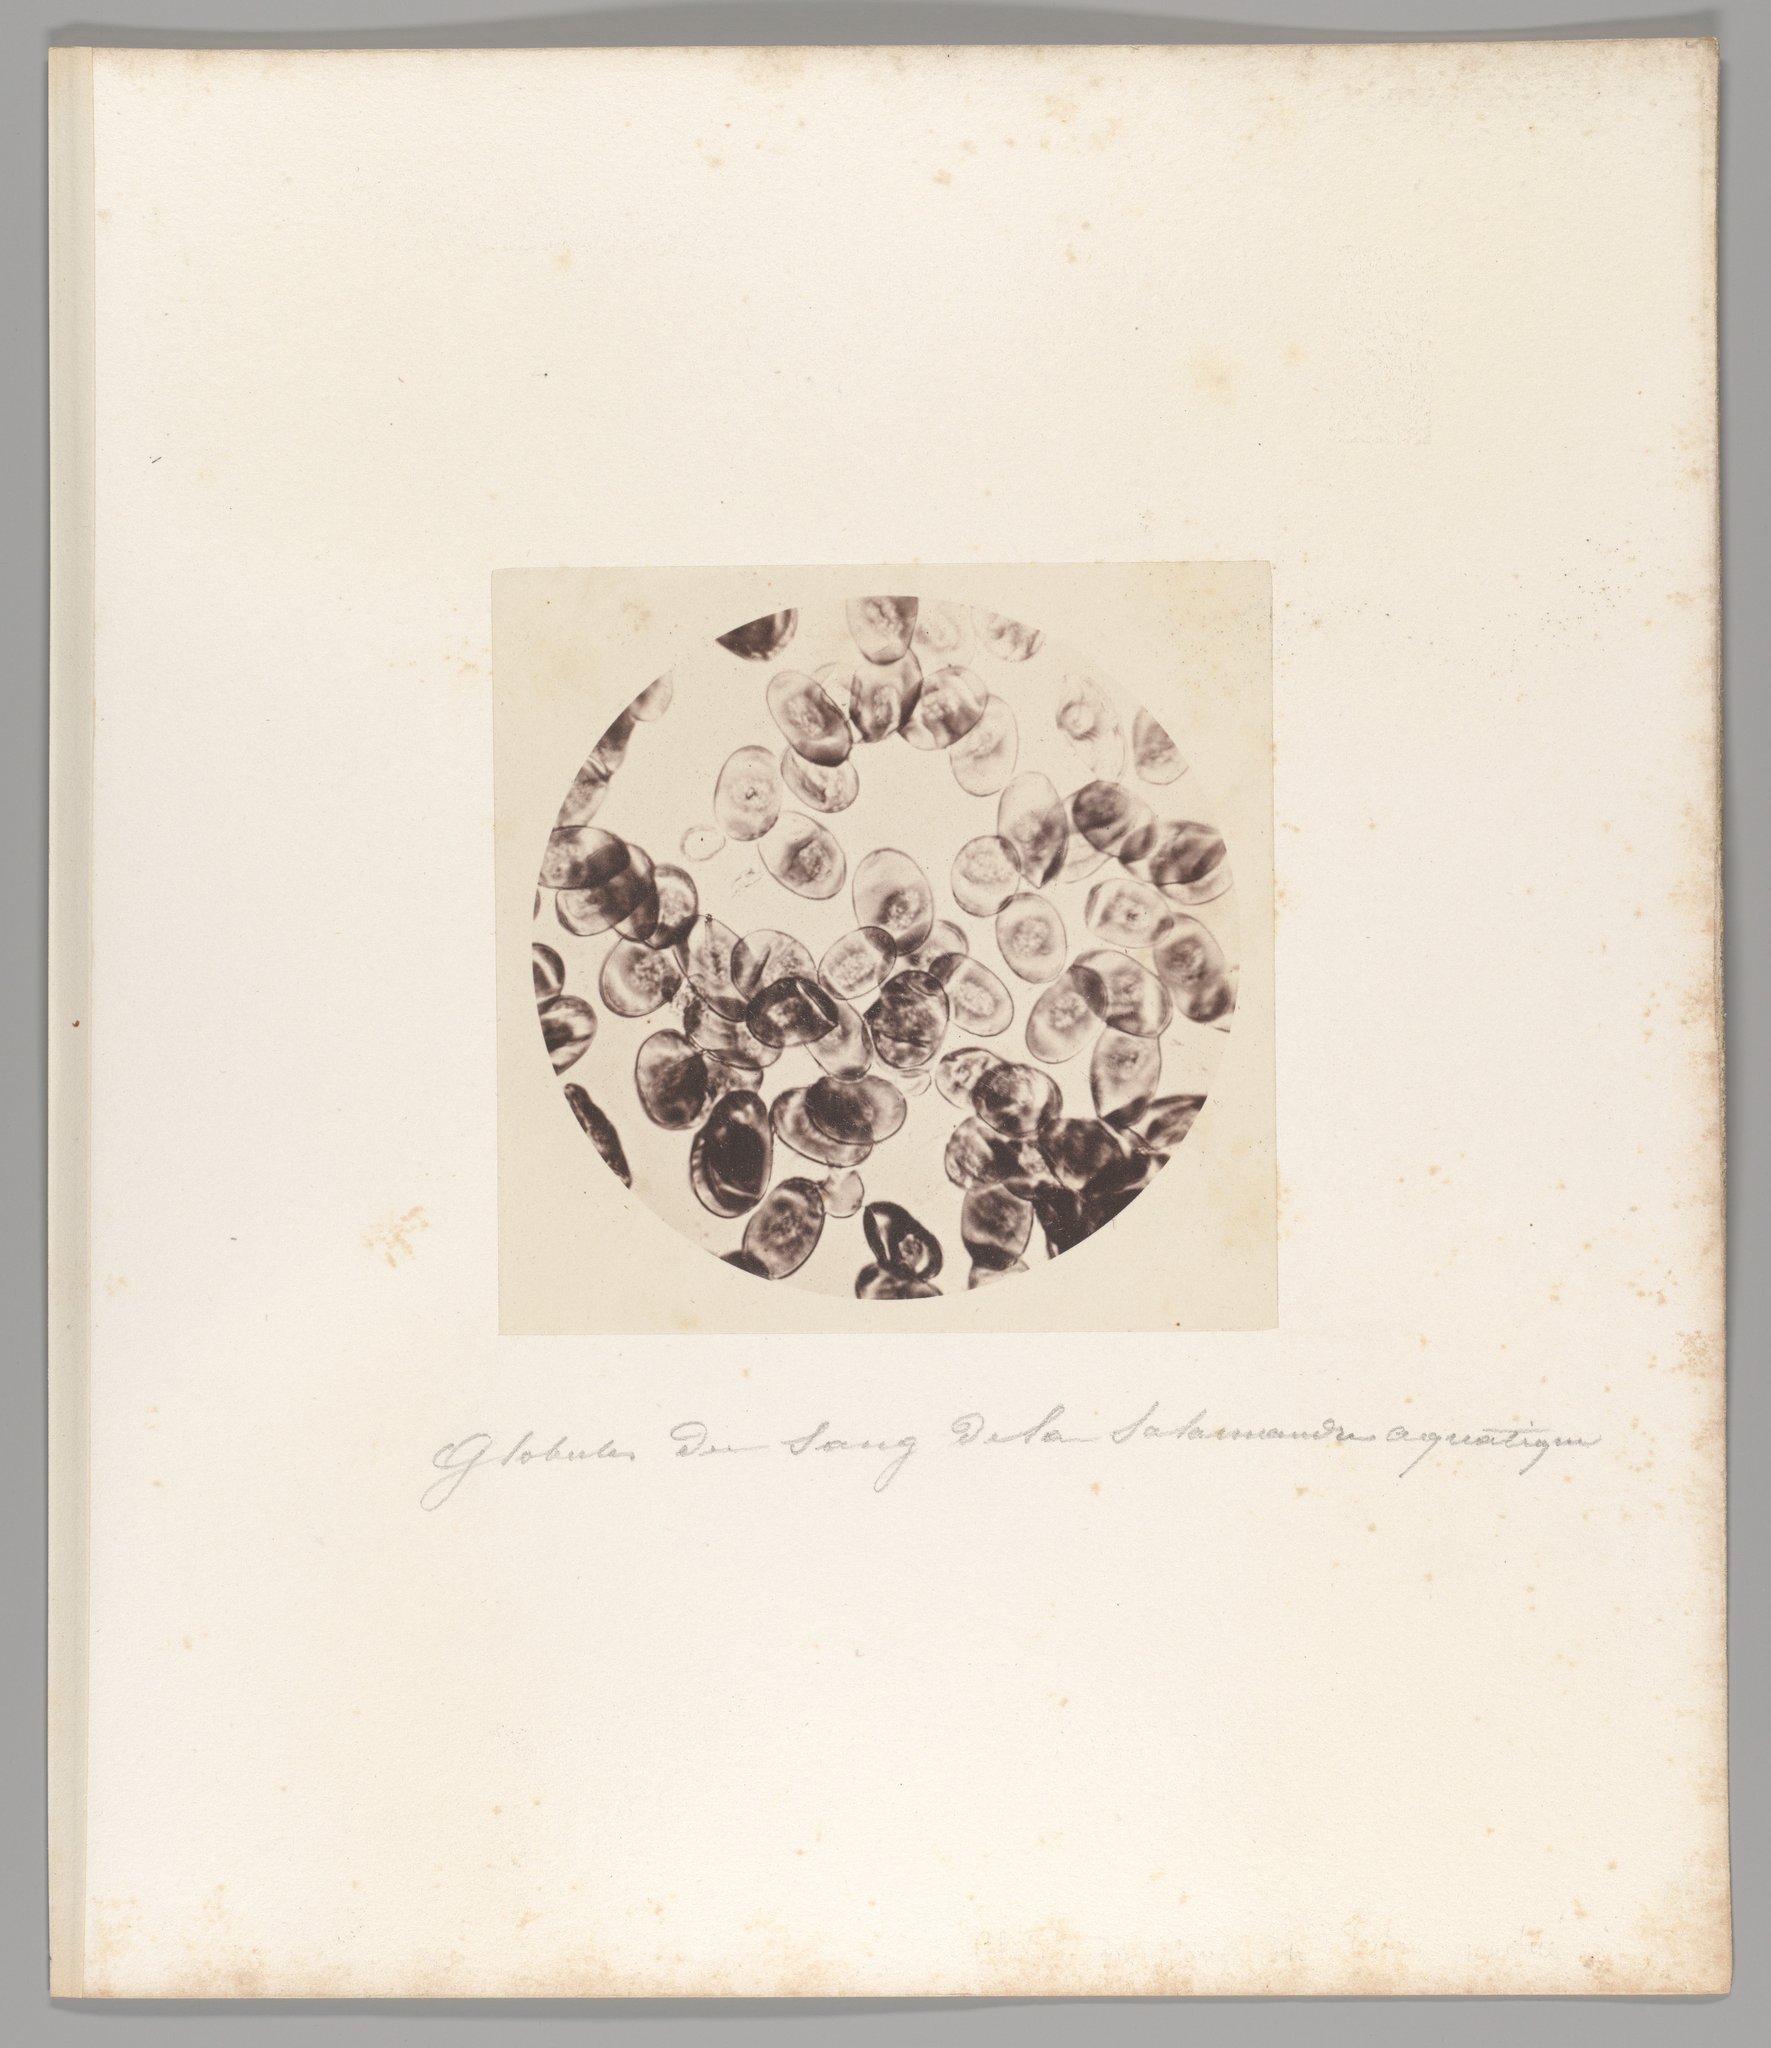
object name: photograph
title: [Untitled]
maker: auguste-adolphe bertsch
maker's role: artist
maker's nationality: french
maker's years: 1813-1871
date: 1853-1857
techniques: salted paper print